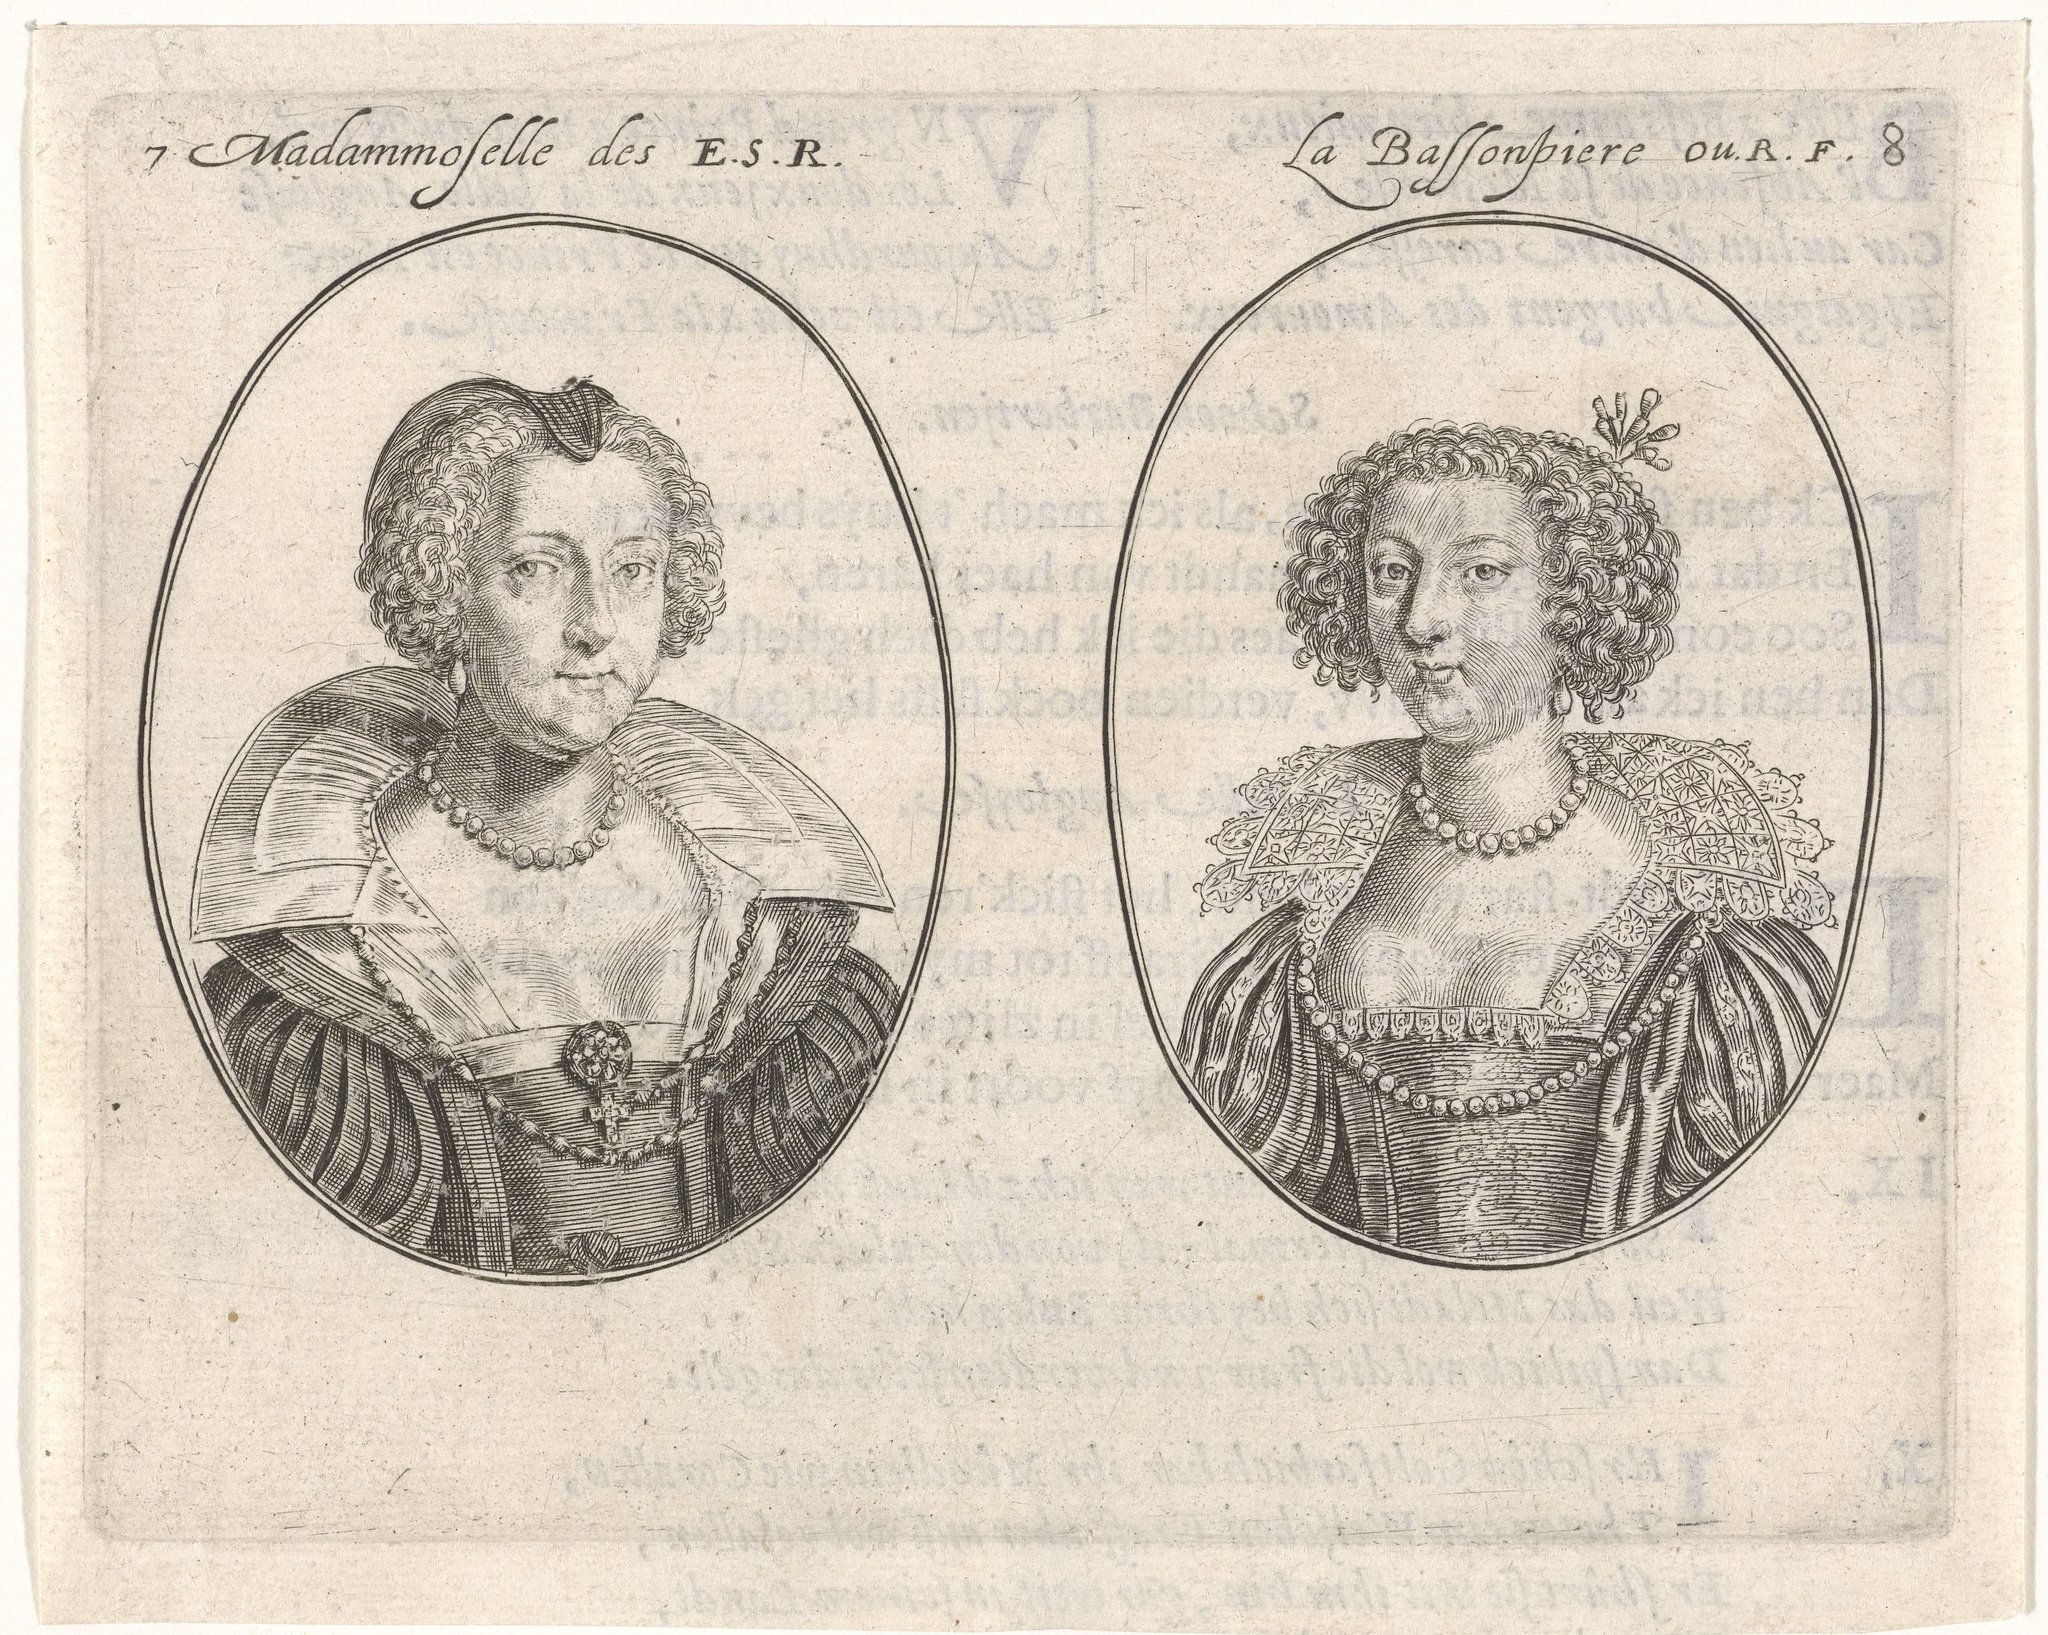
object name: book illustration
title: Le miroir des courtisannes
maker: crispijn van de passe (ii)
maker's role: draughtsman, print maker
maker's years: 1594-1670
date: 1635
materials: paper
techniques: engraving, letterpress printing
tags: whore, prostitute - cc - male prostitution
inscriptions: collector's mark: Lugt 2228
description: Portretten van twee courtisanes die gekleed zijn volgens de mode van hun tijd. In de bovenhoeken genummerd: 7 en 8.